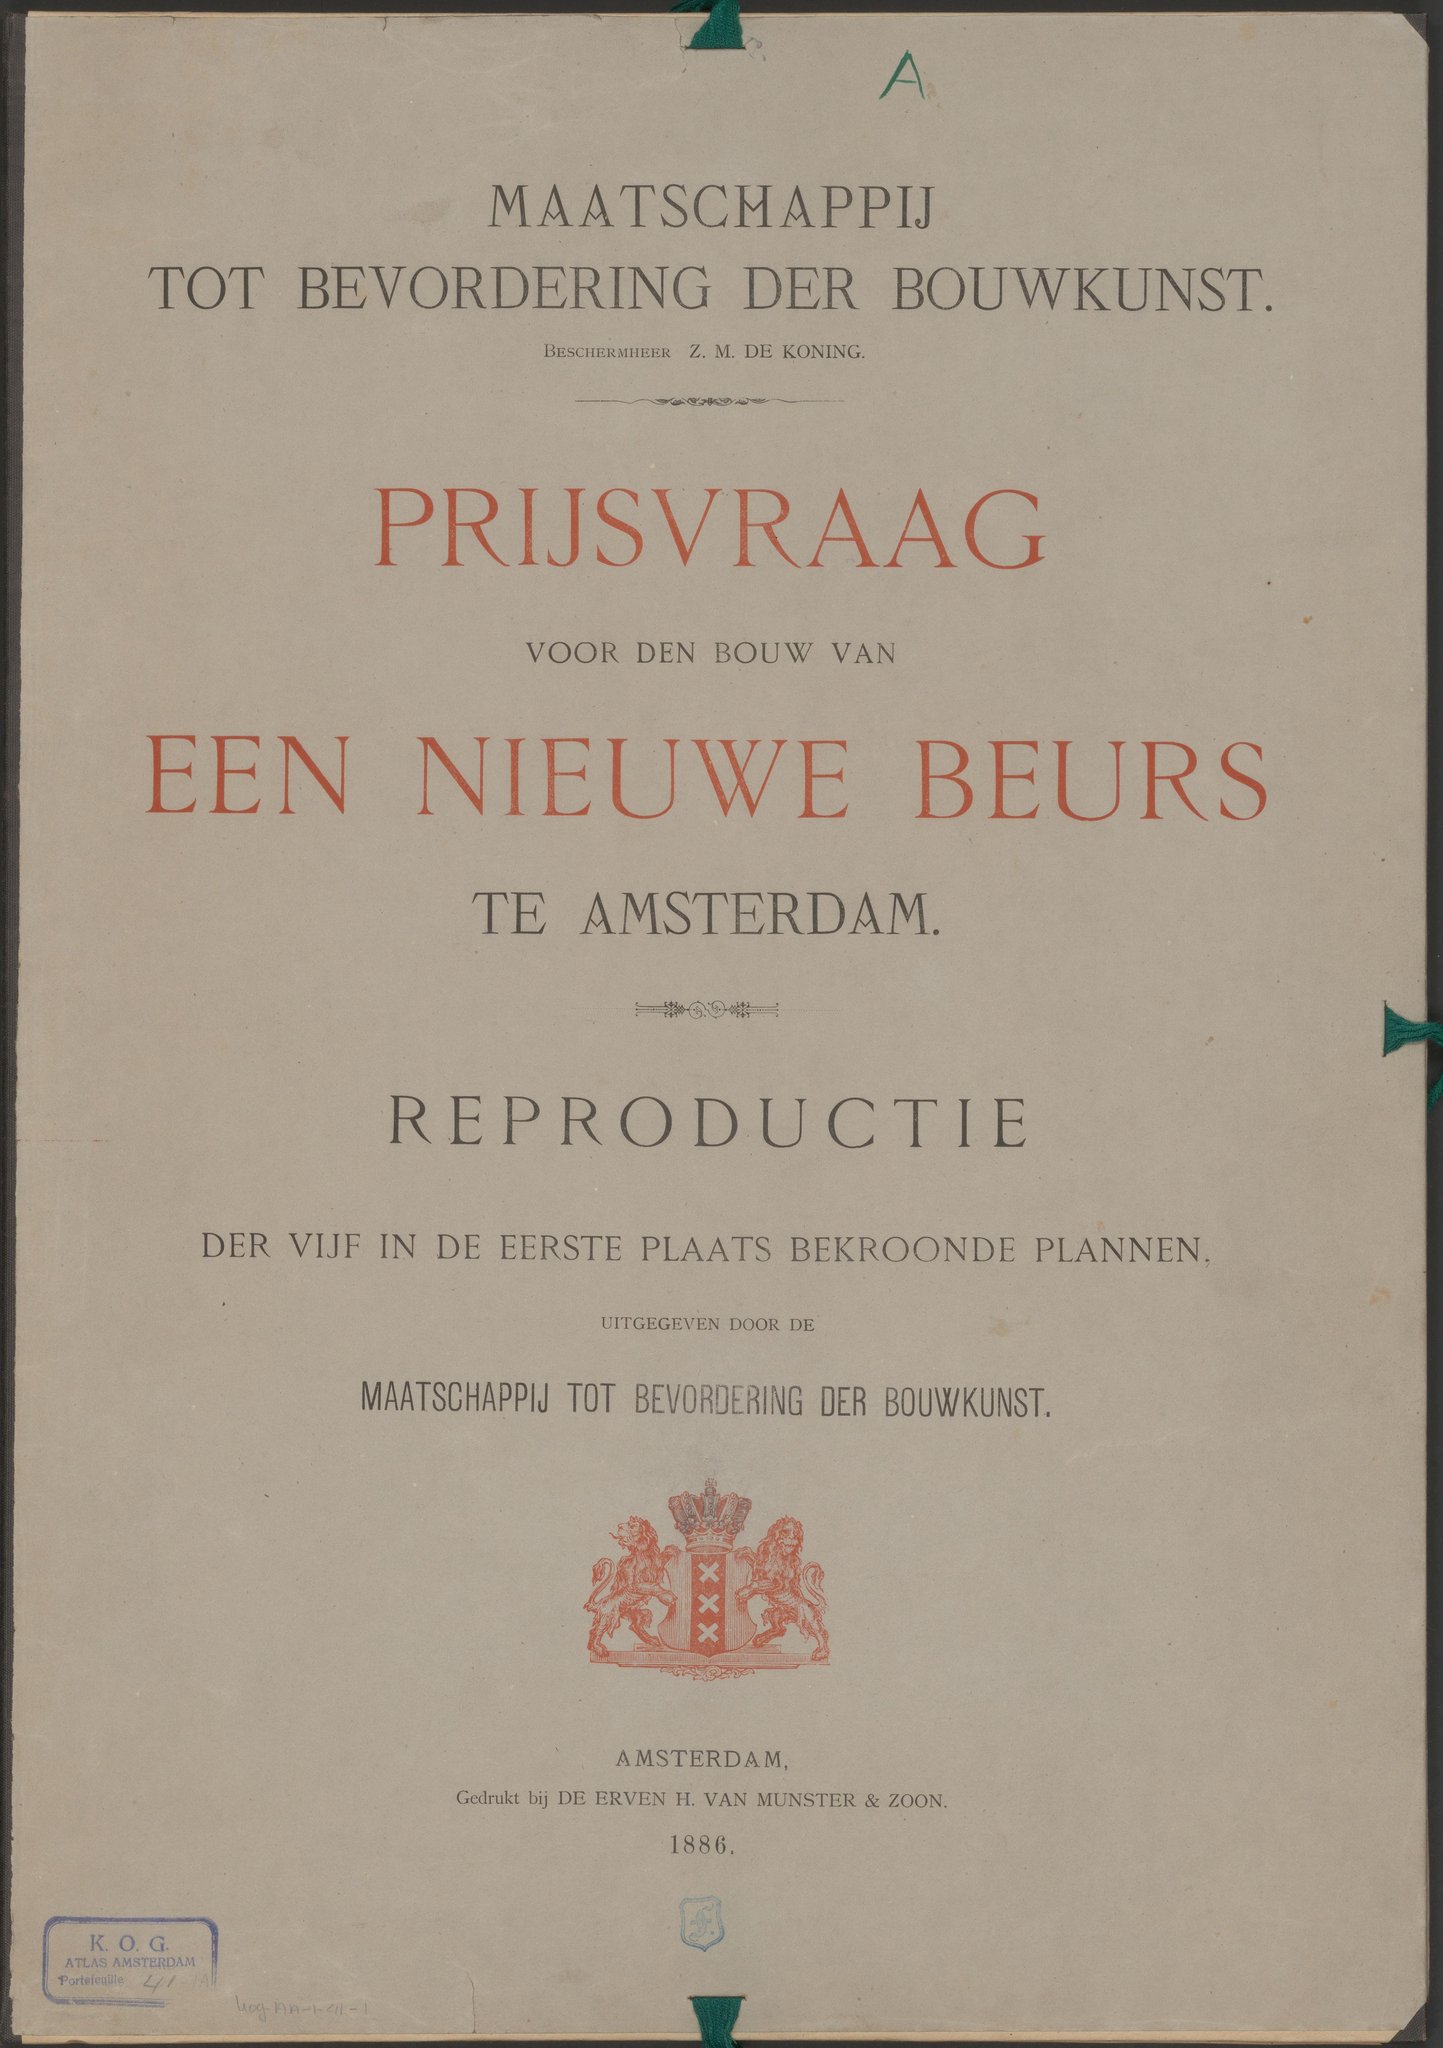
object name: text sheet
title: Omslag voor: Prijsvraag voor den bouw van een nieuwe beurs te Amsterdam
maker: Anonymous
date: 1886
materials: cardboard, paper, textile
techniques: letterpress printing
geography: amsterdam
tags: stock exchange, stock-market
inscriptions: collector's mark: Lugt 1641b, collector's mark: Lugt 963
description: Omslag met een beschrijving van de prijsvraag en het beursterrein en veertien fotomechanische afdrukken met de bekroonde ontwerpen.